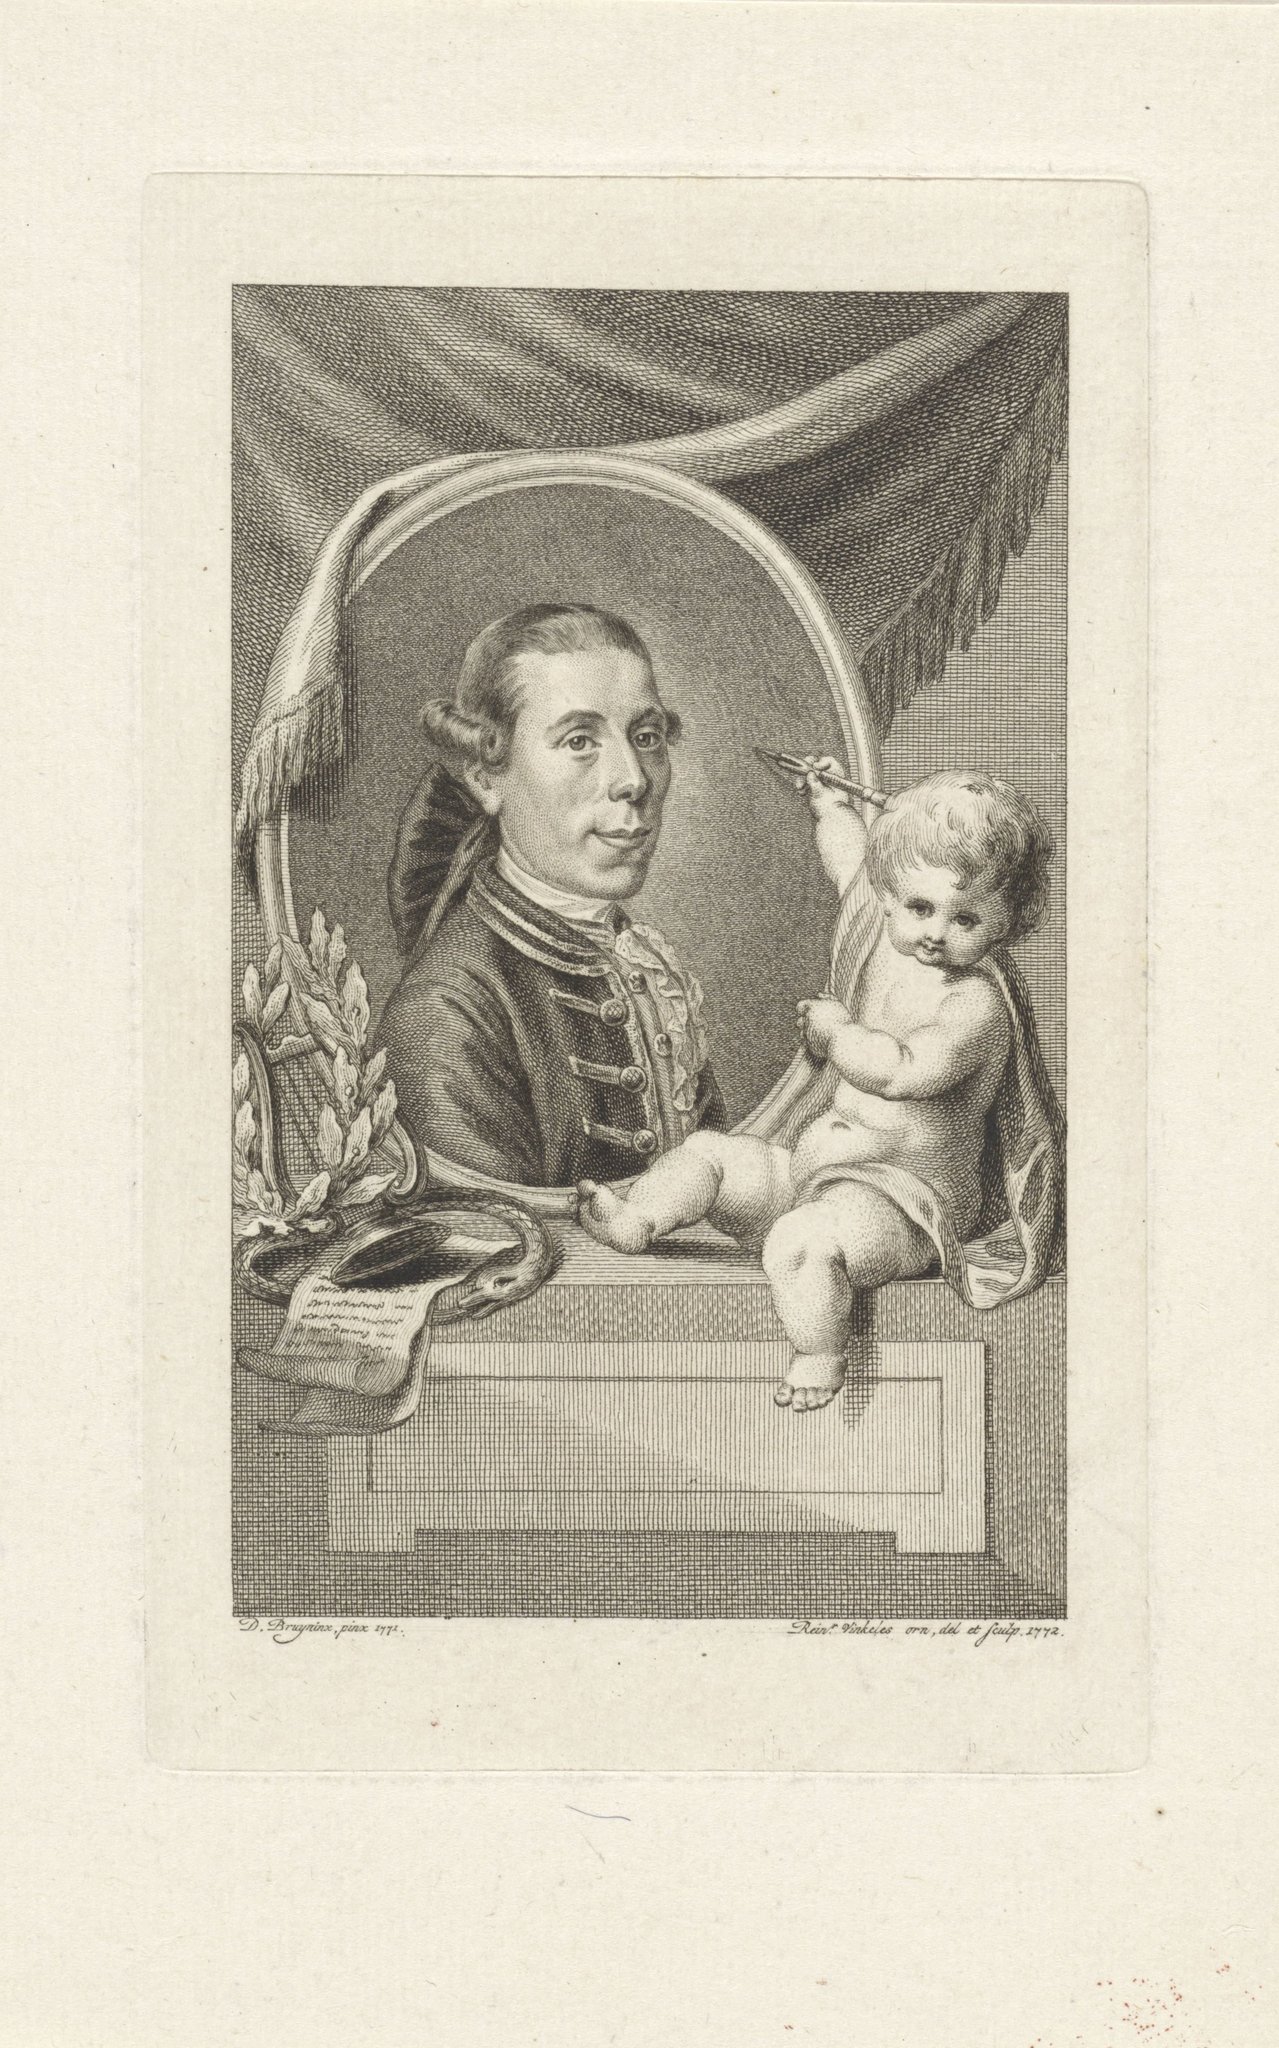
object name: print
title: Portret van Joannes Nomsz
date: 1772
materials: paper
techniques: engraving, etching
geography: amsterdam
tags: joannes nomsz, honouring the artist with laurel wreath, lyre, cithara, psaltery, tools, implements of graphic artist, serpent ouroboros, cupids: 'amores', 'amoretti', 'putti'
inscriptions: collector's mark: Lugt 240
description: Portret van Joannes Nomsz, schrijver, dichter en toneelschijver. Naast het portret en putto met een etsnaal en links een lauwerkrans, lier, beschreven vellen papier en het eeuwigheidssymbool de Ouroboros.